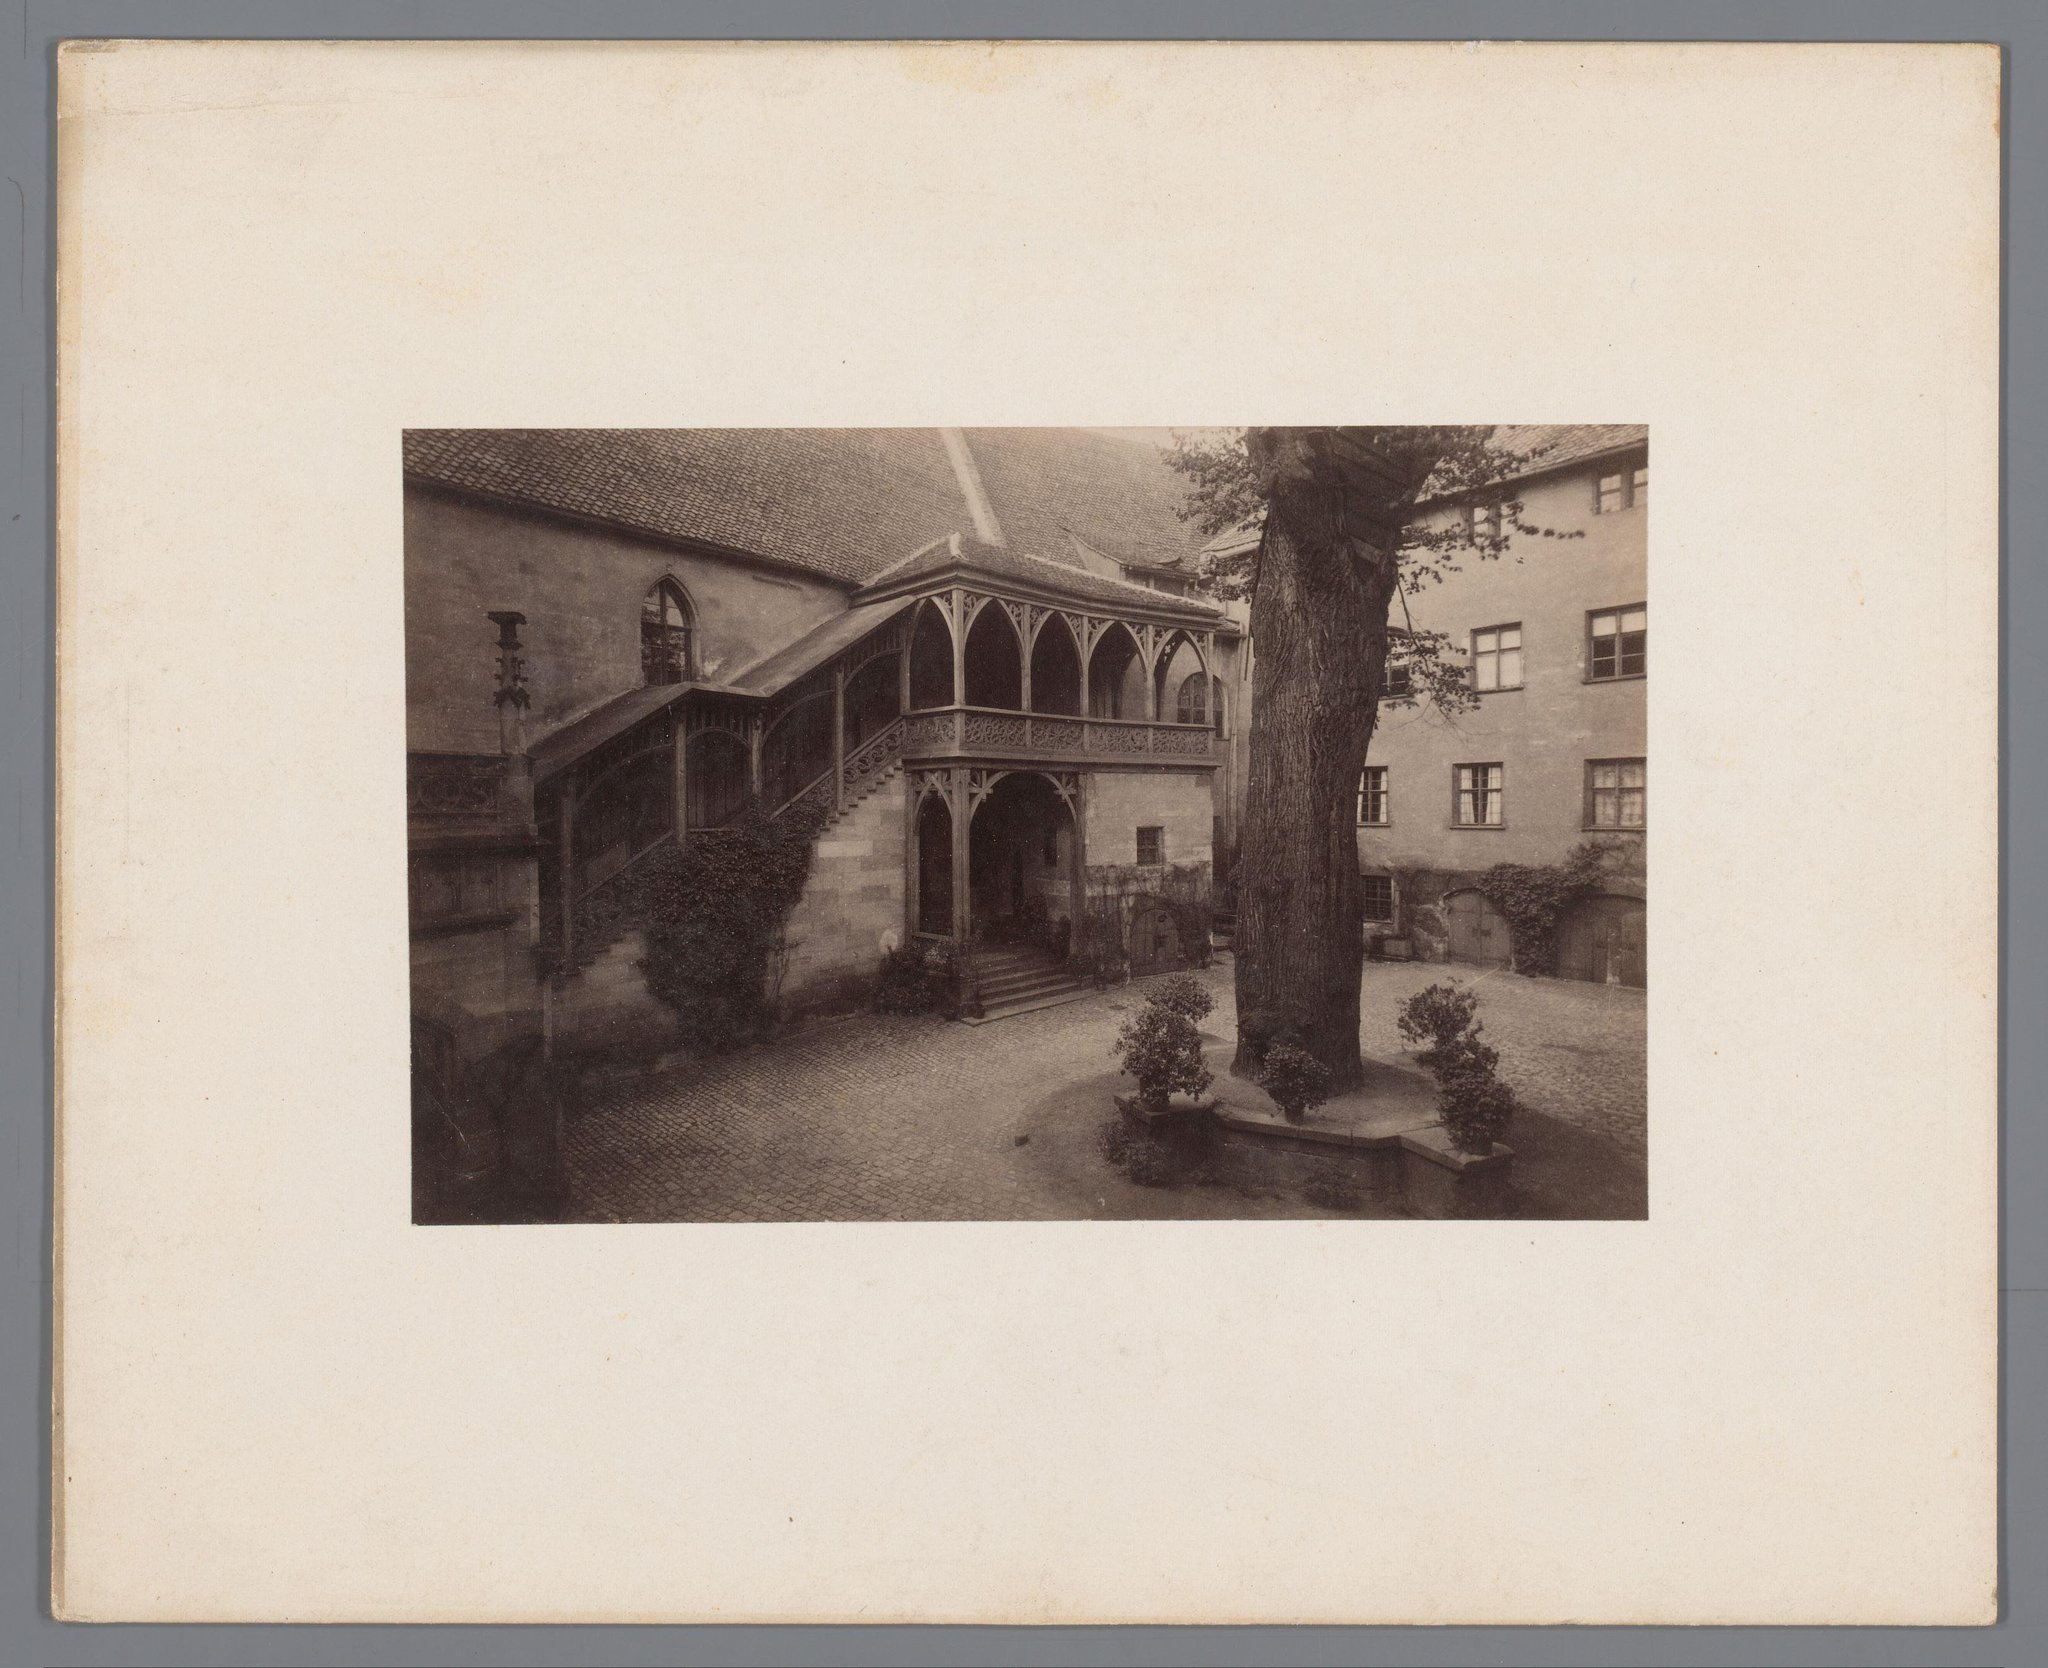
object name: photograph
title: Gezicht op binnenplaats met hoge boom, huizen en een omgang met spitsbogen en veranda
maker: Anonymous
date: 1890-1910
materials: cardboard, paper, photographic support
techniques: collodion silver print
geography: france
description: Gezicht op binnenplaats met hoge boom, huizen en een omgang met spitsbogen en veranda.